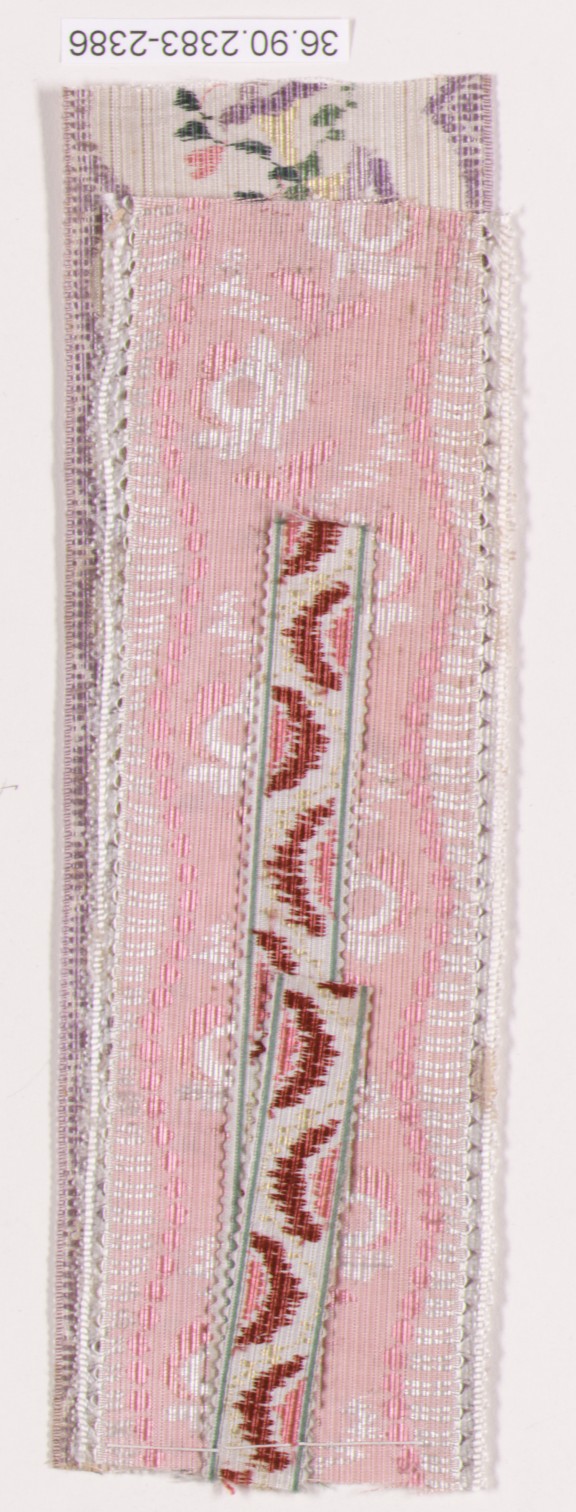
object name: ribbon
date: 1801-1900